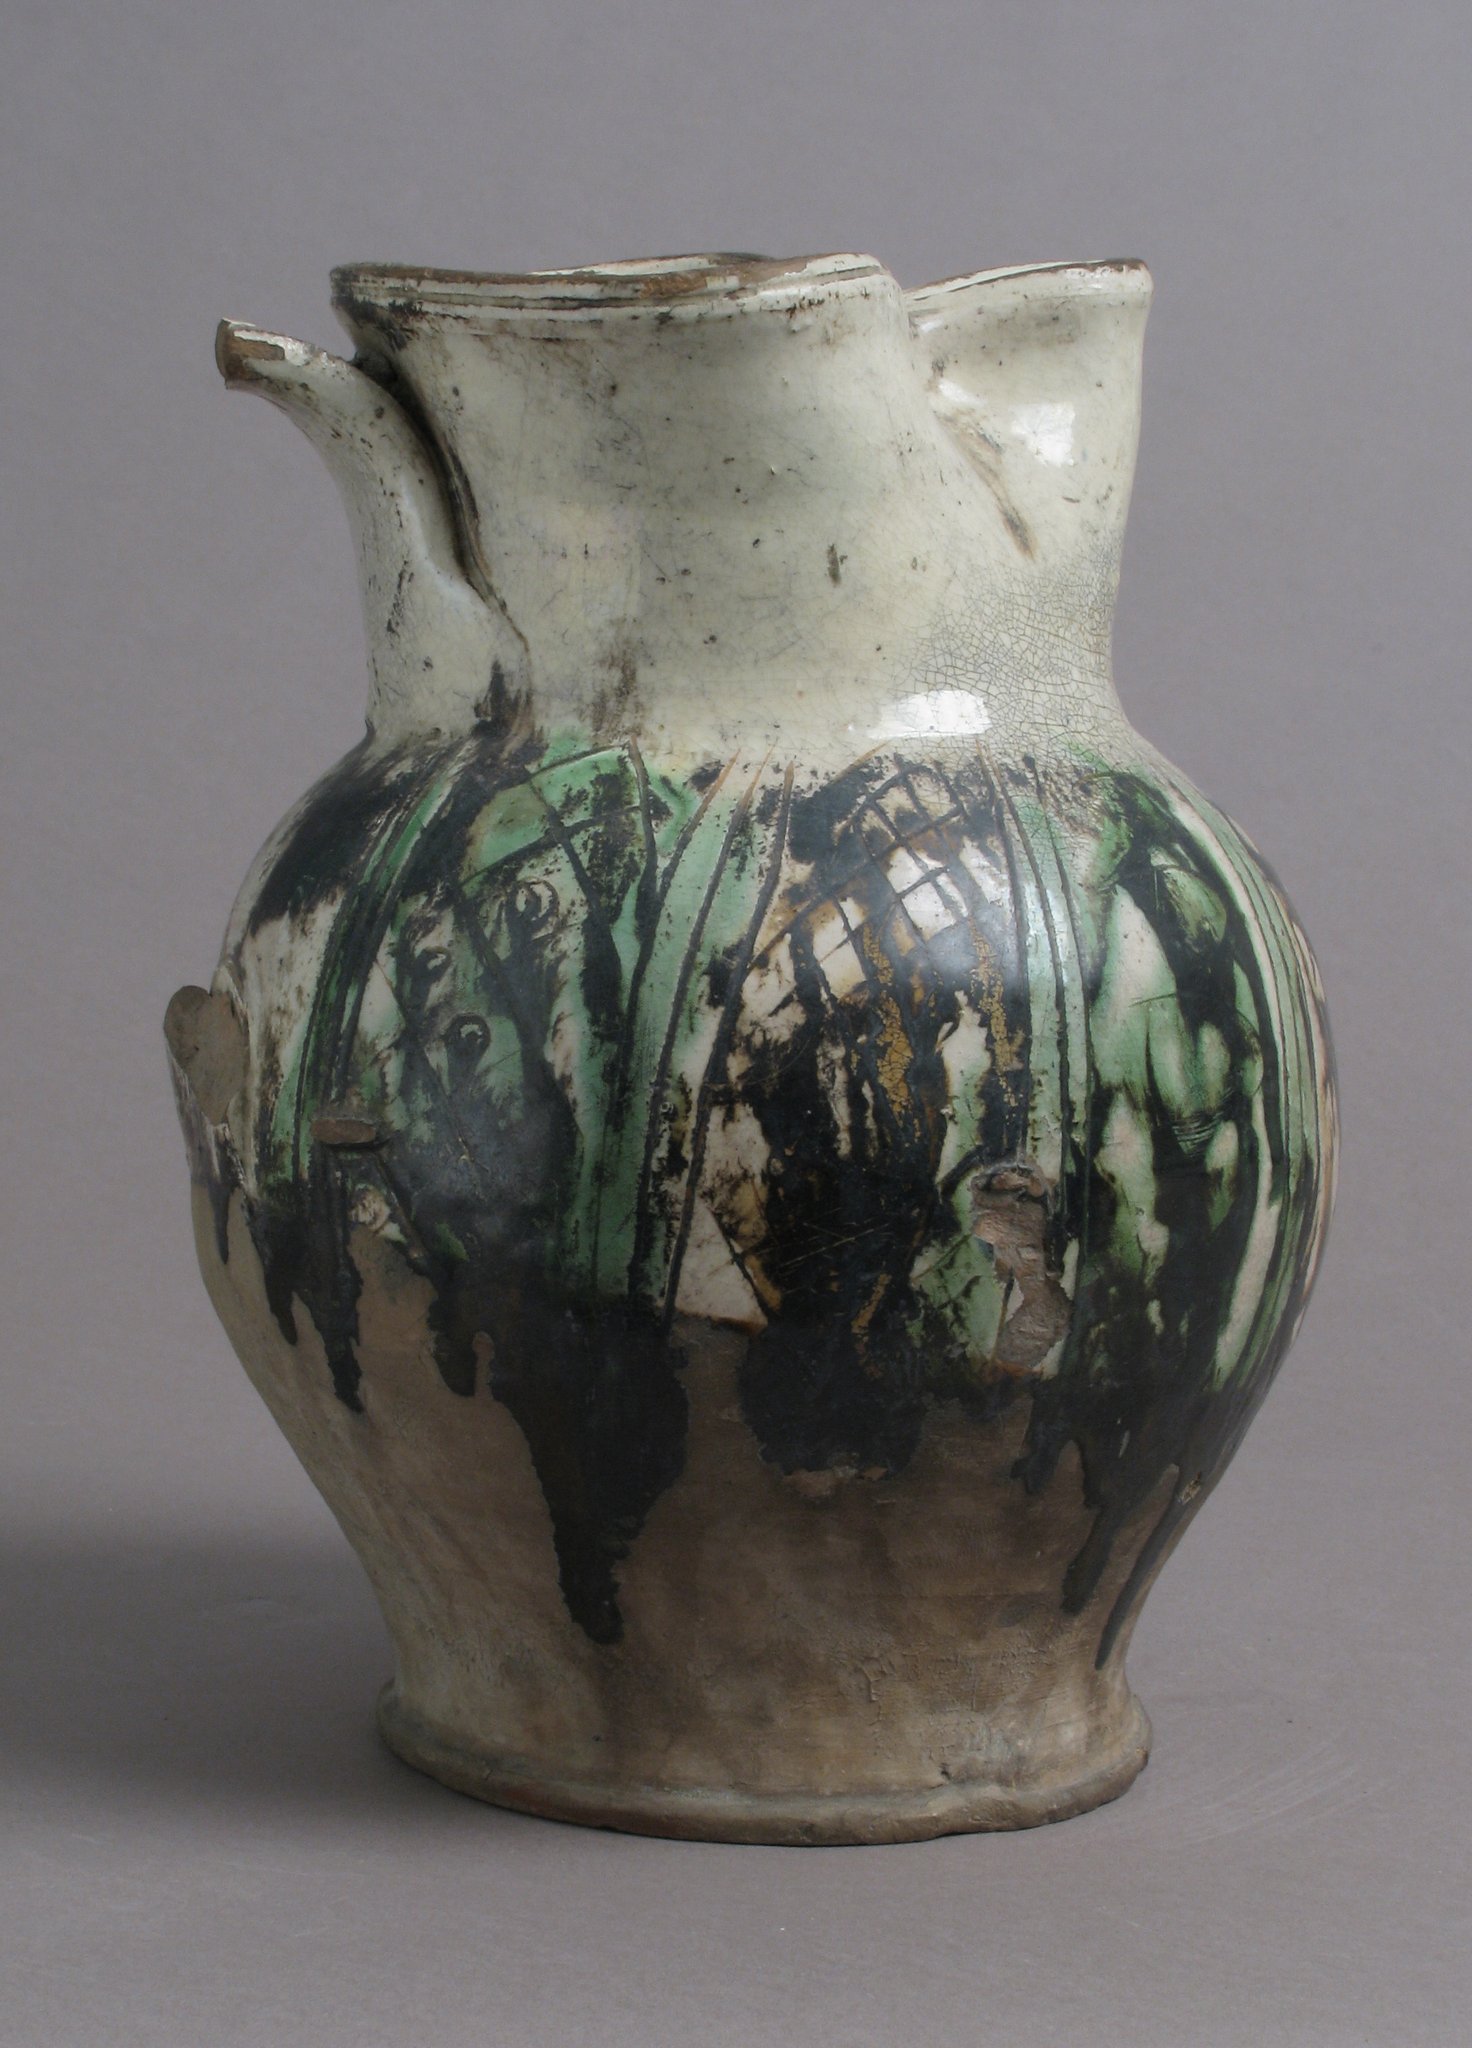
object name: jug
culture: italian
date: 1401-1500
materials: earthenware, glaze